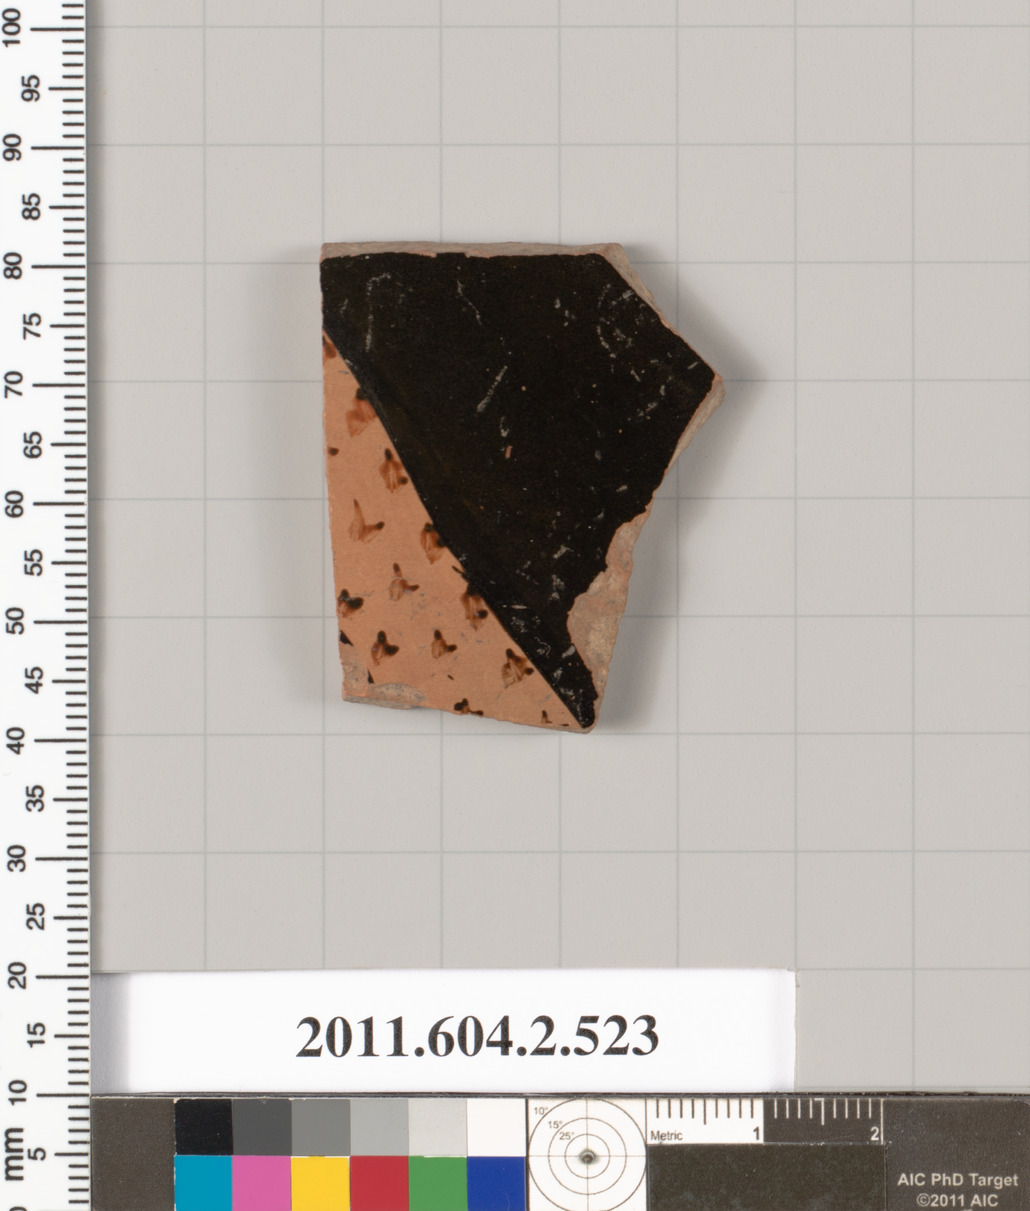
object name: column krater fragment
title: Terracotta fragment of a column-krater (bowl for mixing wine and water)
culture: greek, attic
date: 460-440 BCE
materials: terracotta